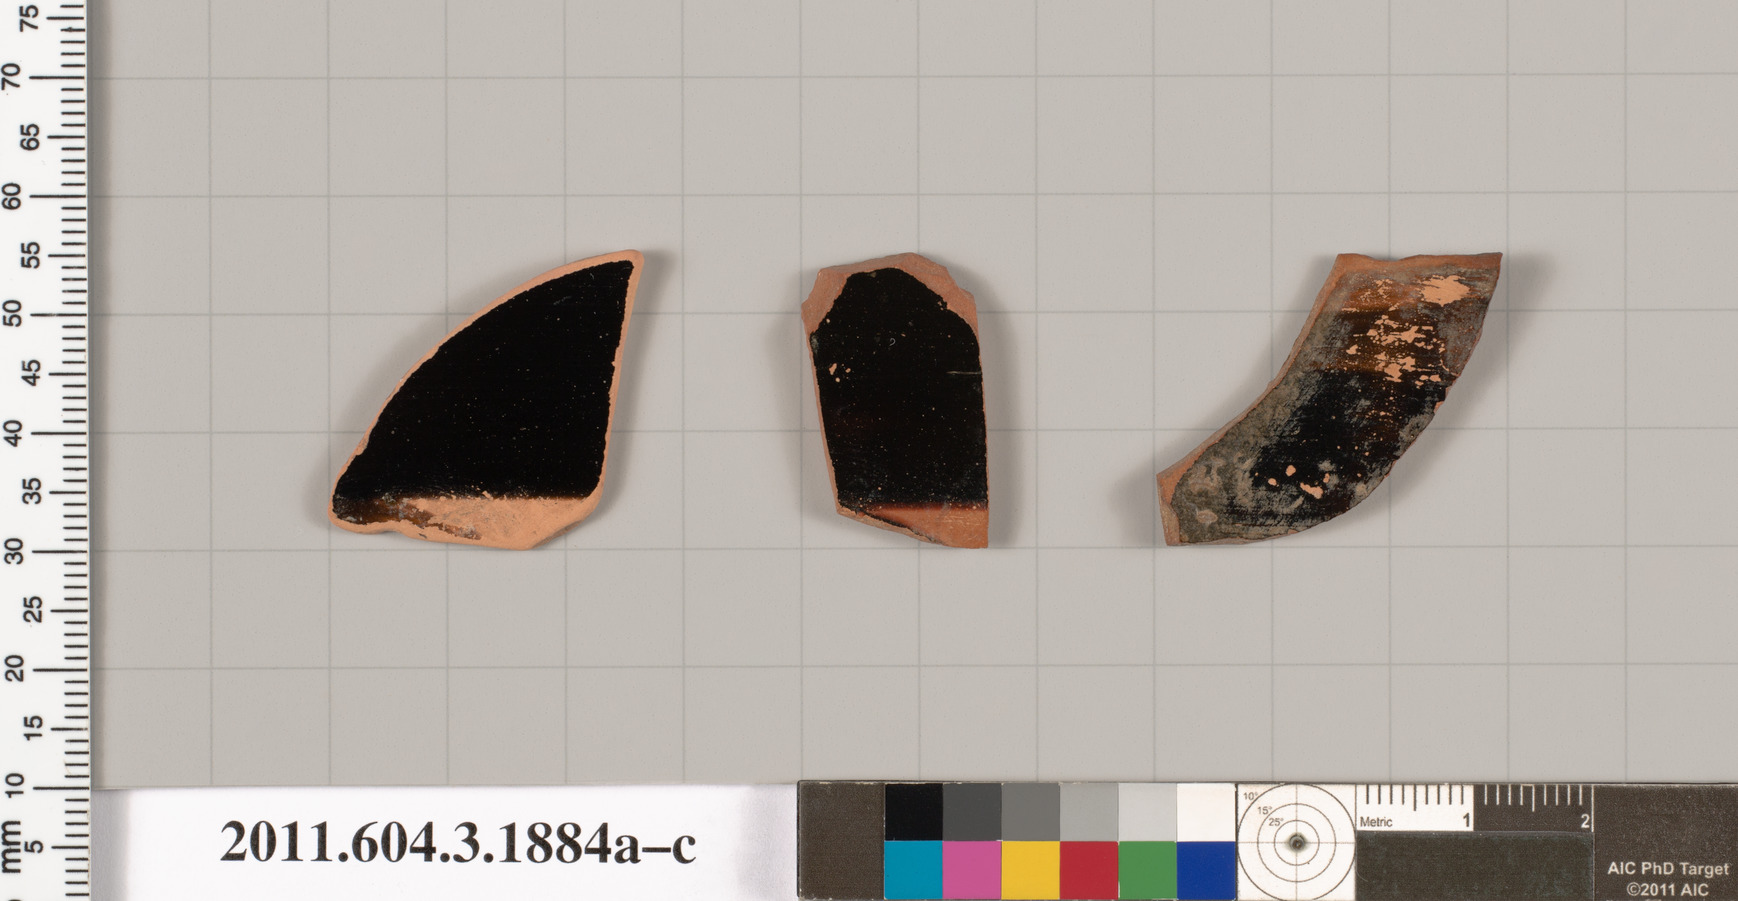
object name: undetermined shape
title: Terracotta fragments from undetermined shapes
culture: greek, attic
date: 600-401 BCE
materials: terracotta